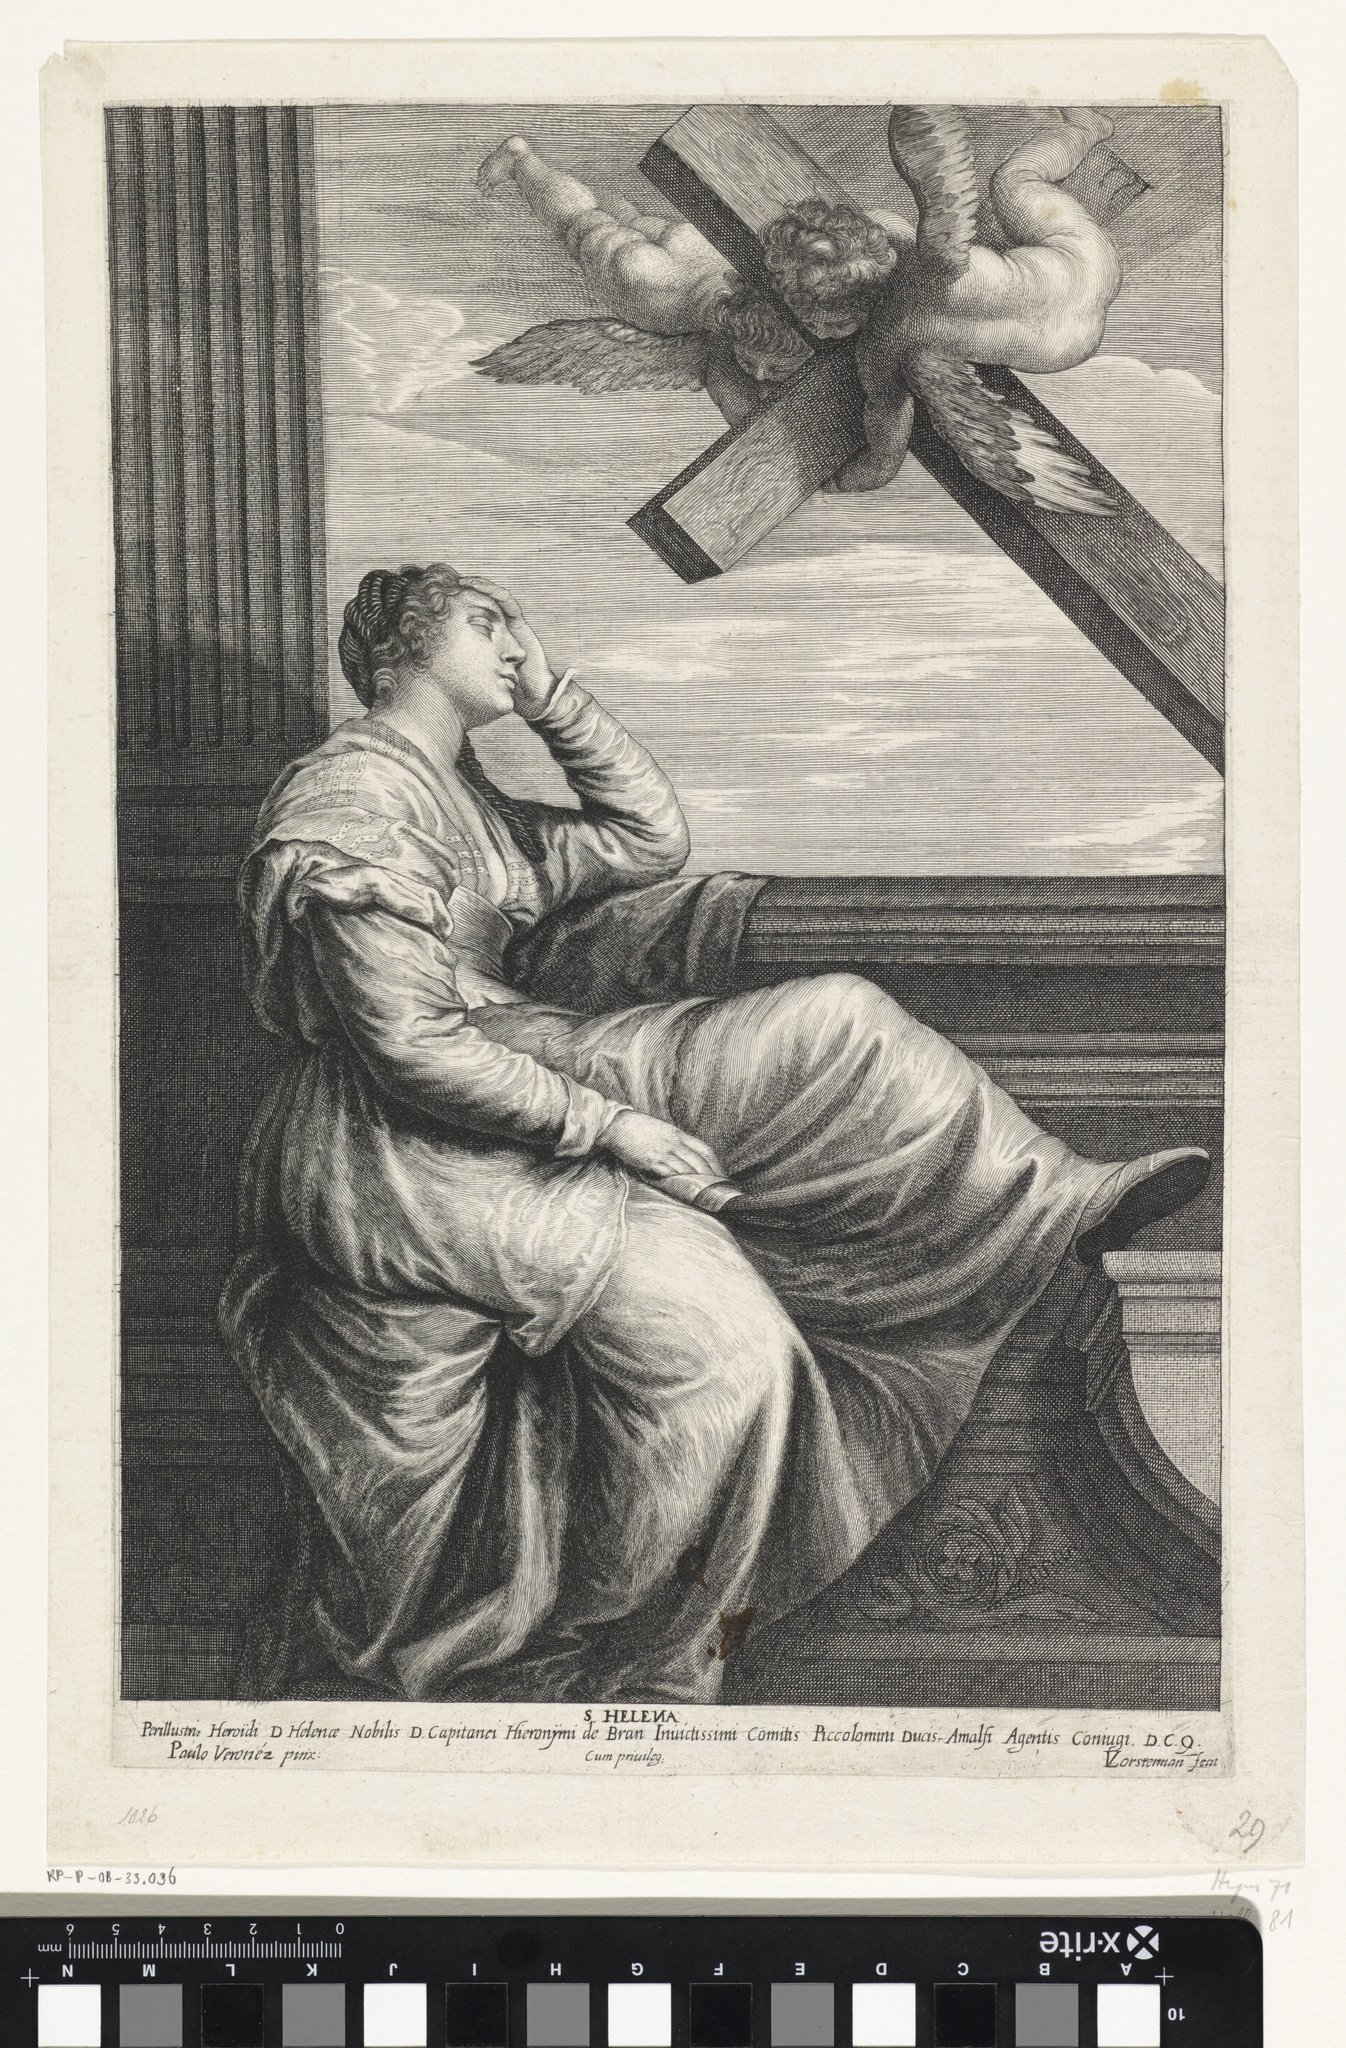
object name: print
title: H. Helena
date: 1619-1675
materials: paper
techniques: engraving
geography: antwerp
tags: empress helena, mother of constantine the great; possible attributes: model of church, (royal) crown, crown of thorns, cross, three nails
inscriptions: collector's mark: Lugt 240